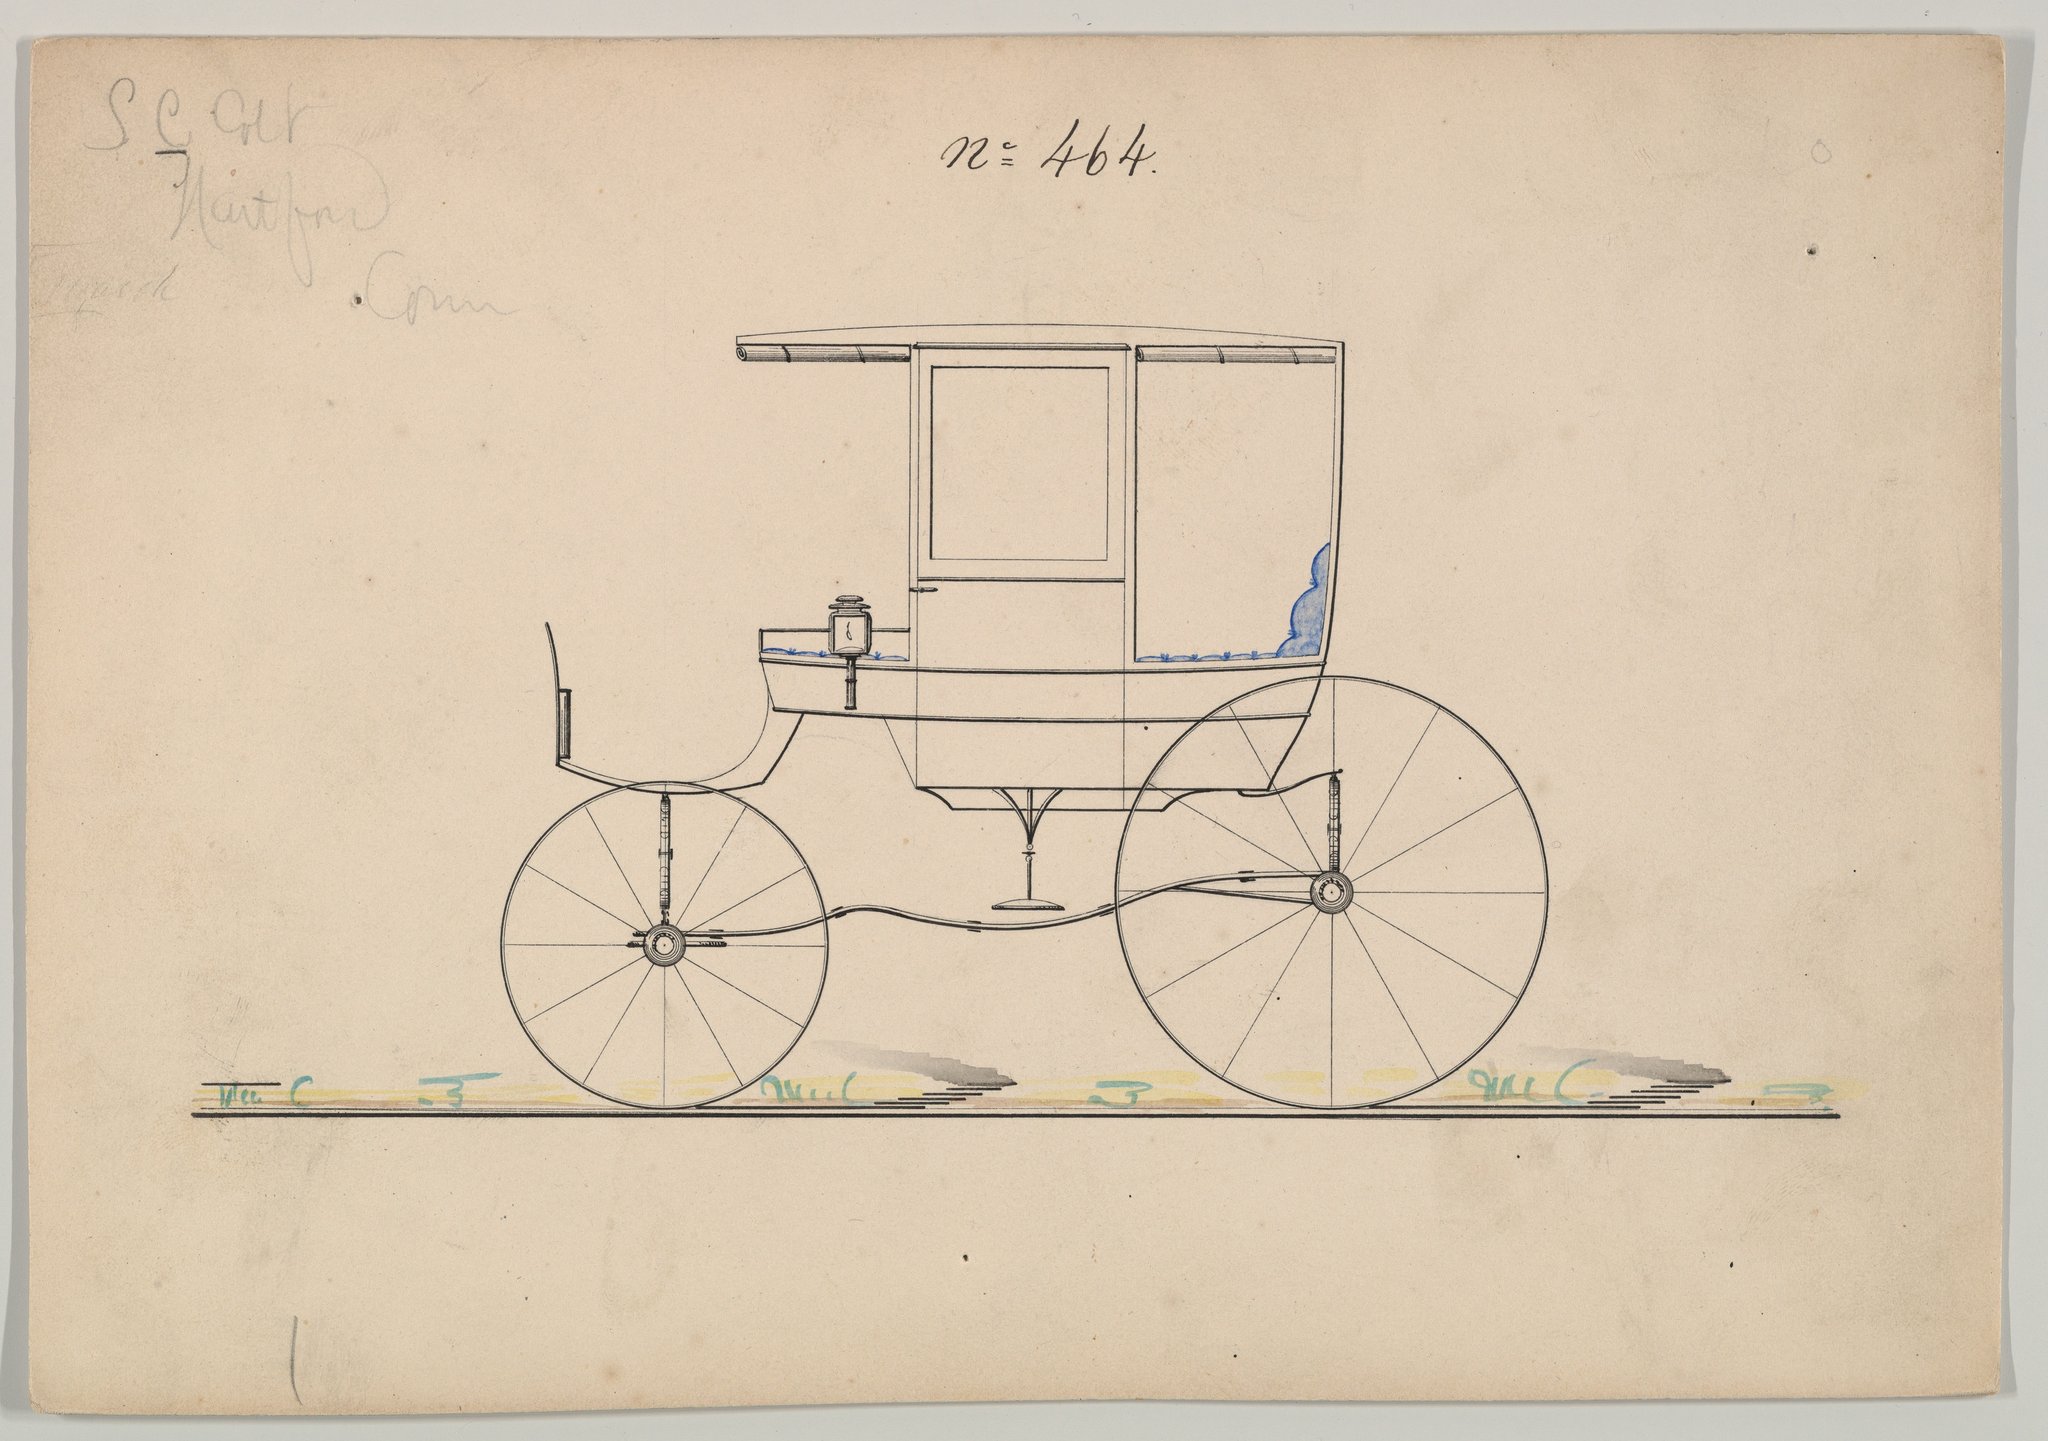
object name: drawing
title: Rockaway #464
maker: brewster & co.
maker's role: manufacturer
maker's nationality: american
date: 1860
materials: gouache, ink, watercolor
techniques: pen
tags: carriages